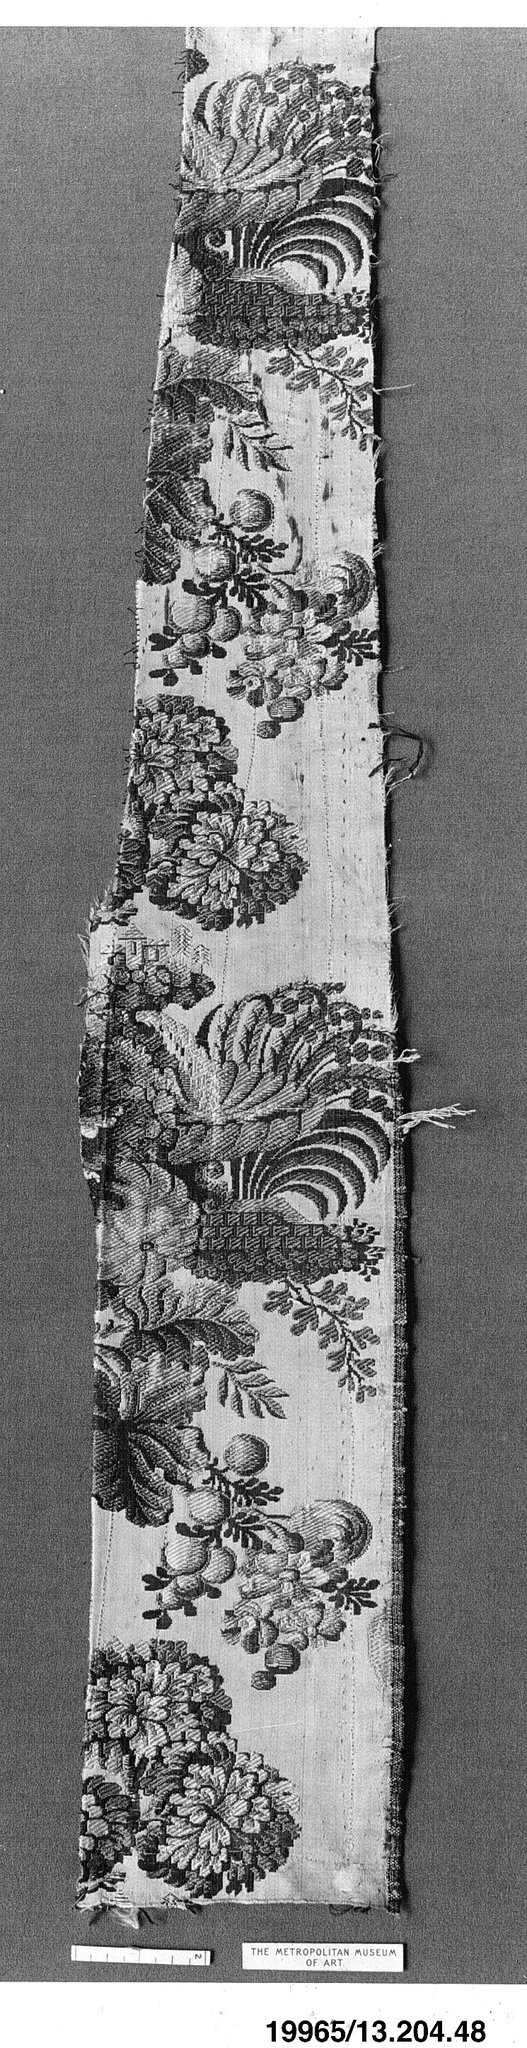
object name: piece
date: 1735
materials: silk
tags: flowers,leaves